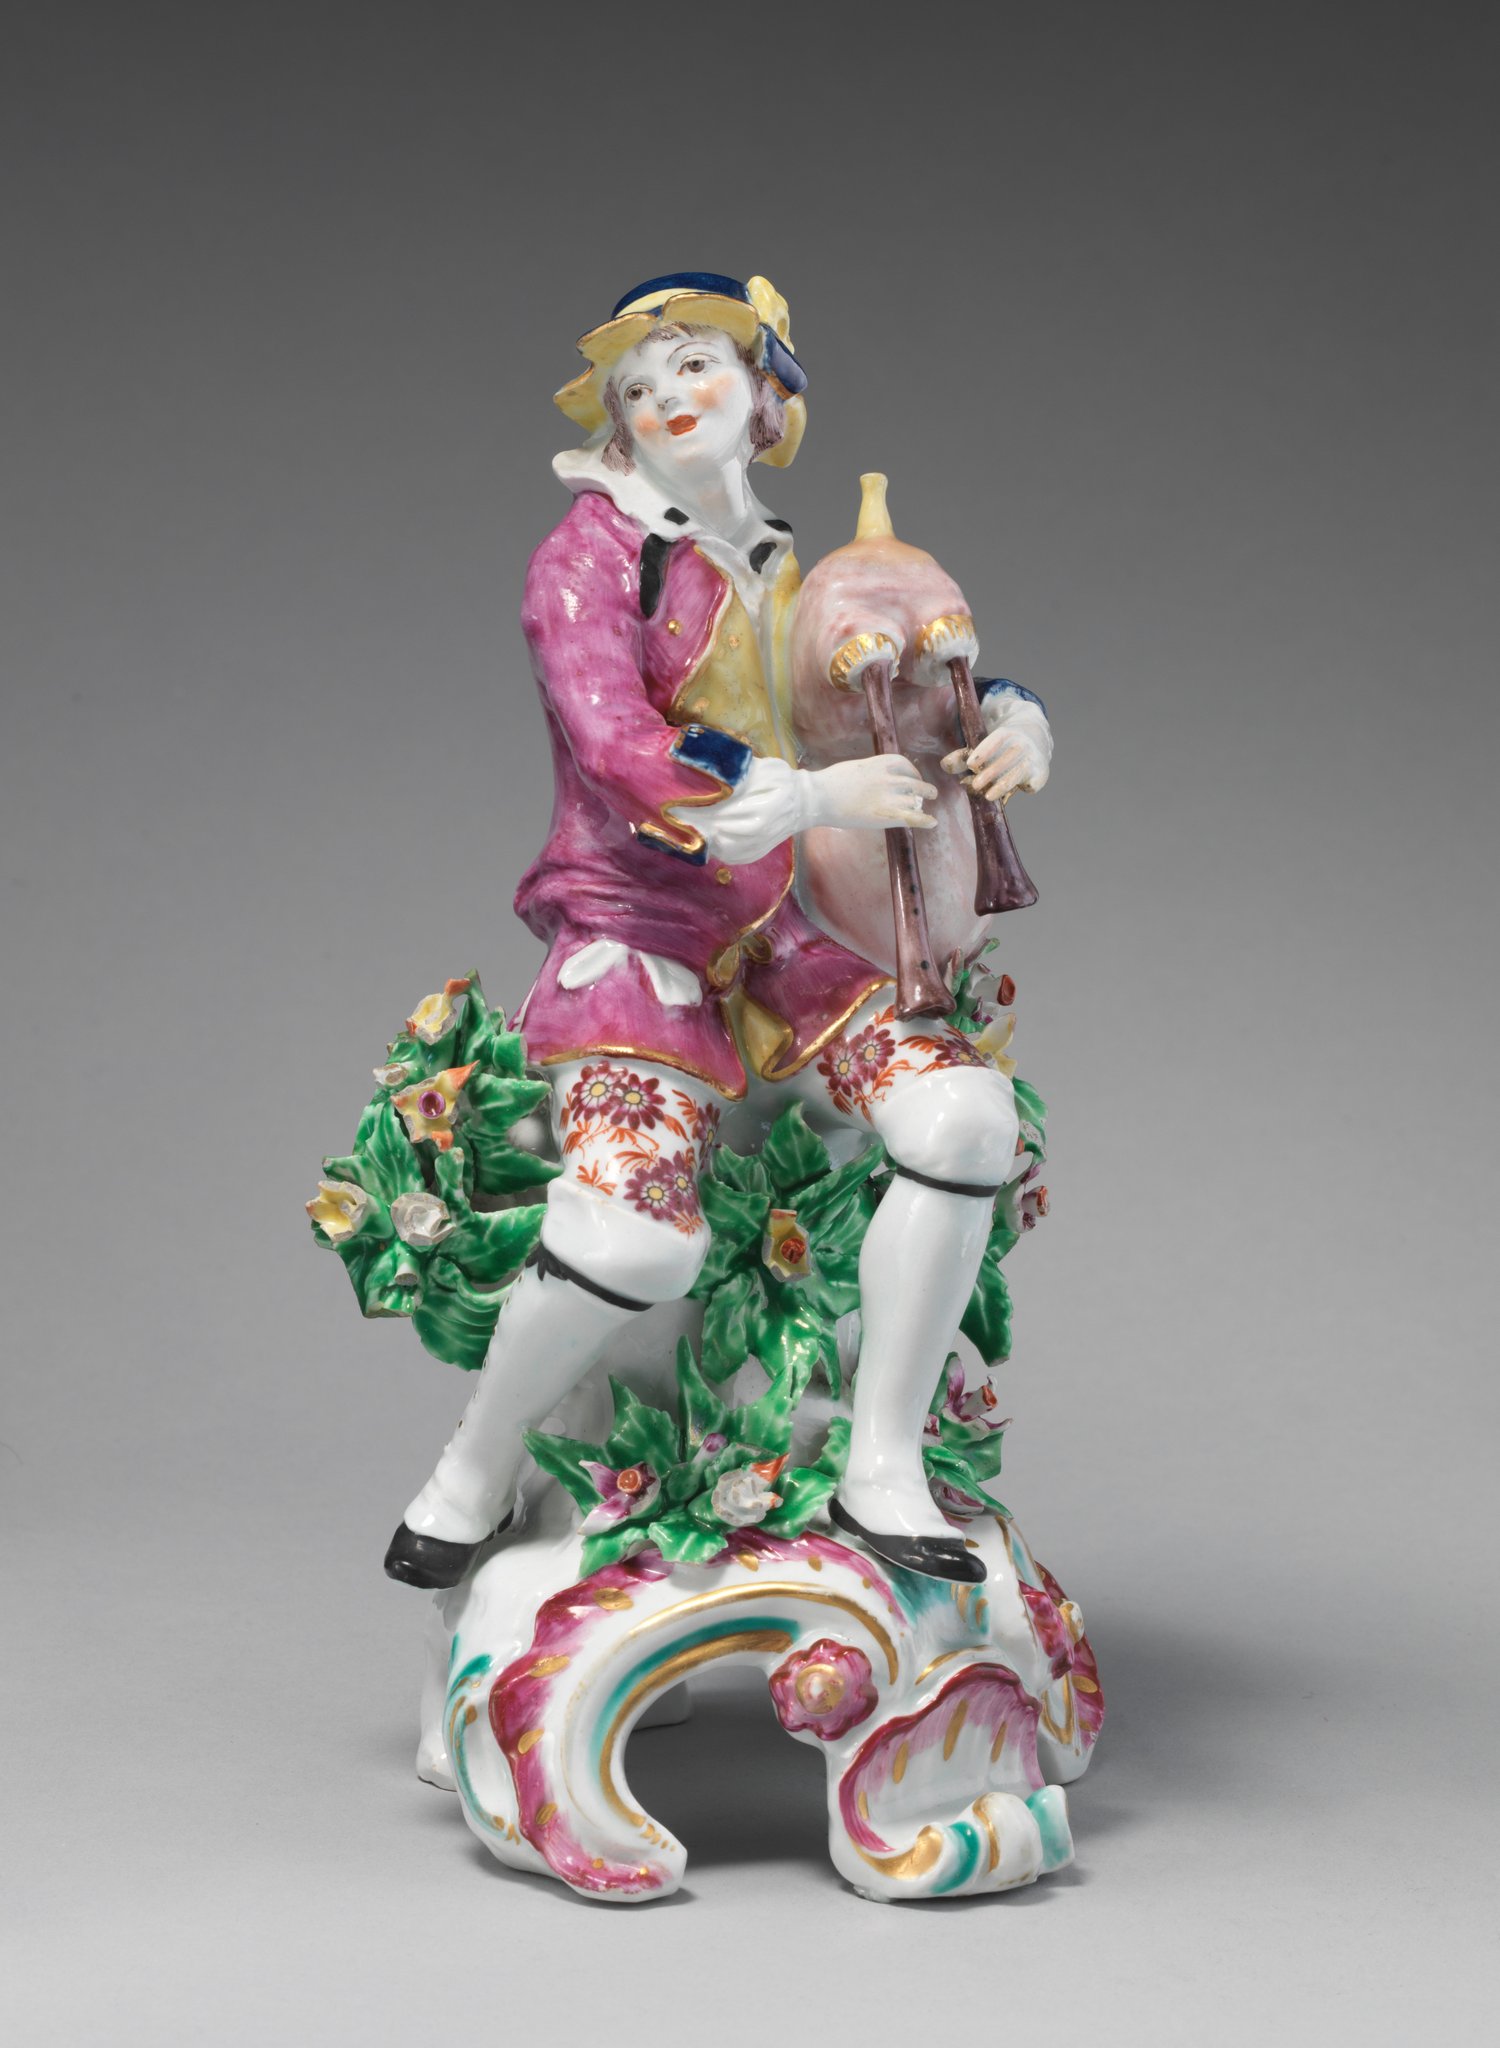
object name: figure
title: Seated musician (one of a pair)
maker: bow porcelain factory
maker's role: factory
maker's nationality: british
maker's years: 1747-1776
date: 1765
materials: soft paste porcelain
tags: men,bagpipes,musicians